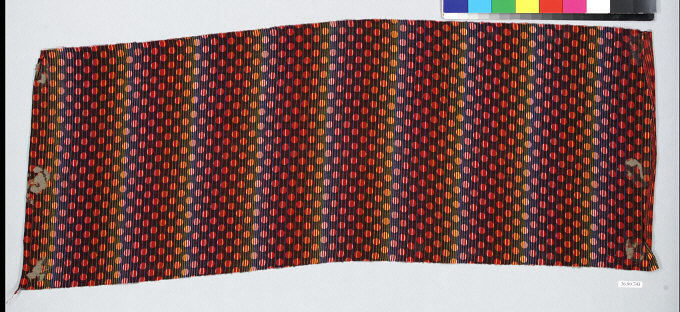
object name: piece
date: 1867-1900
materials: cotton